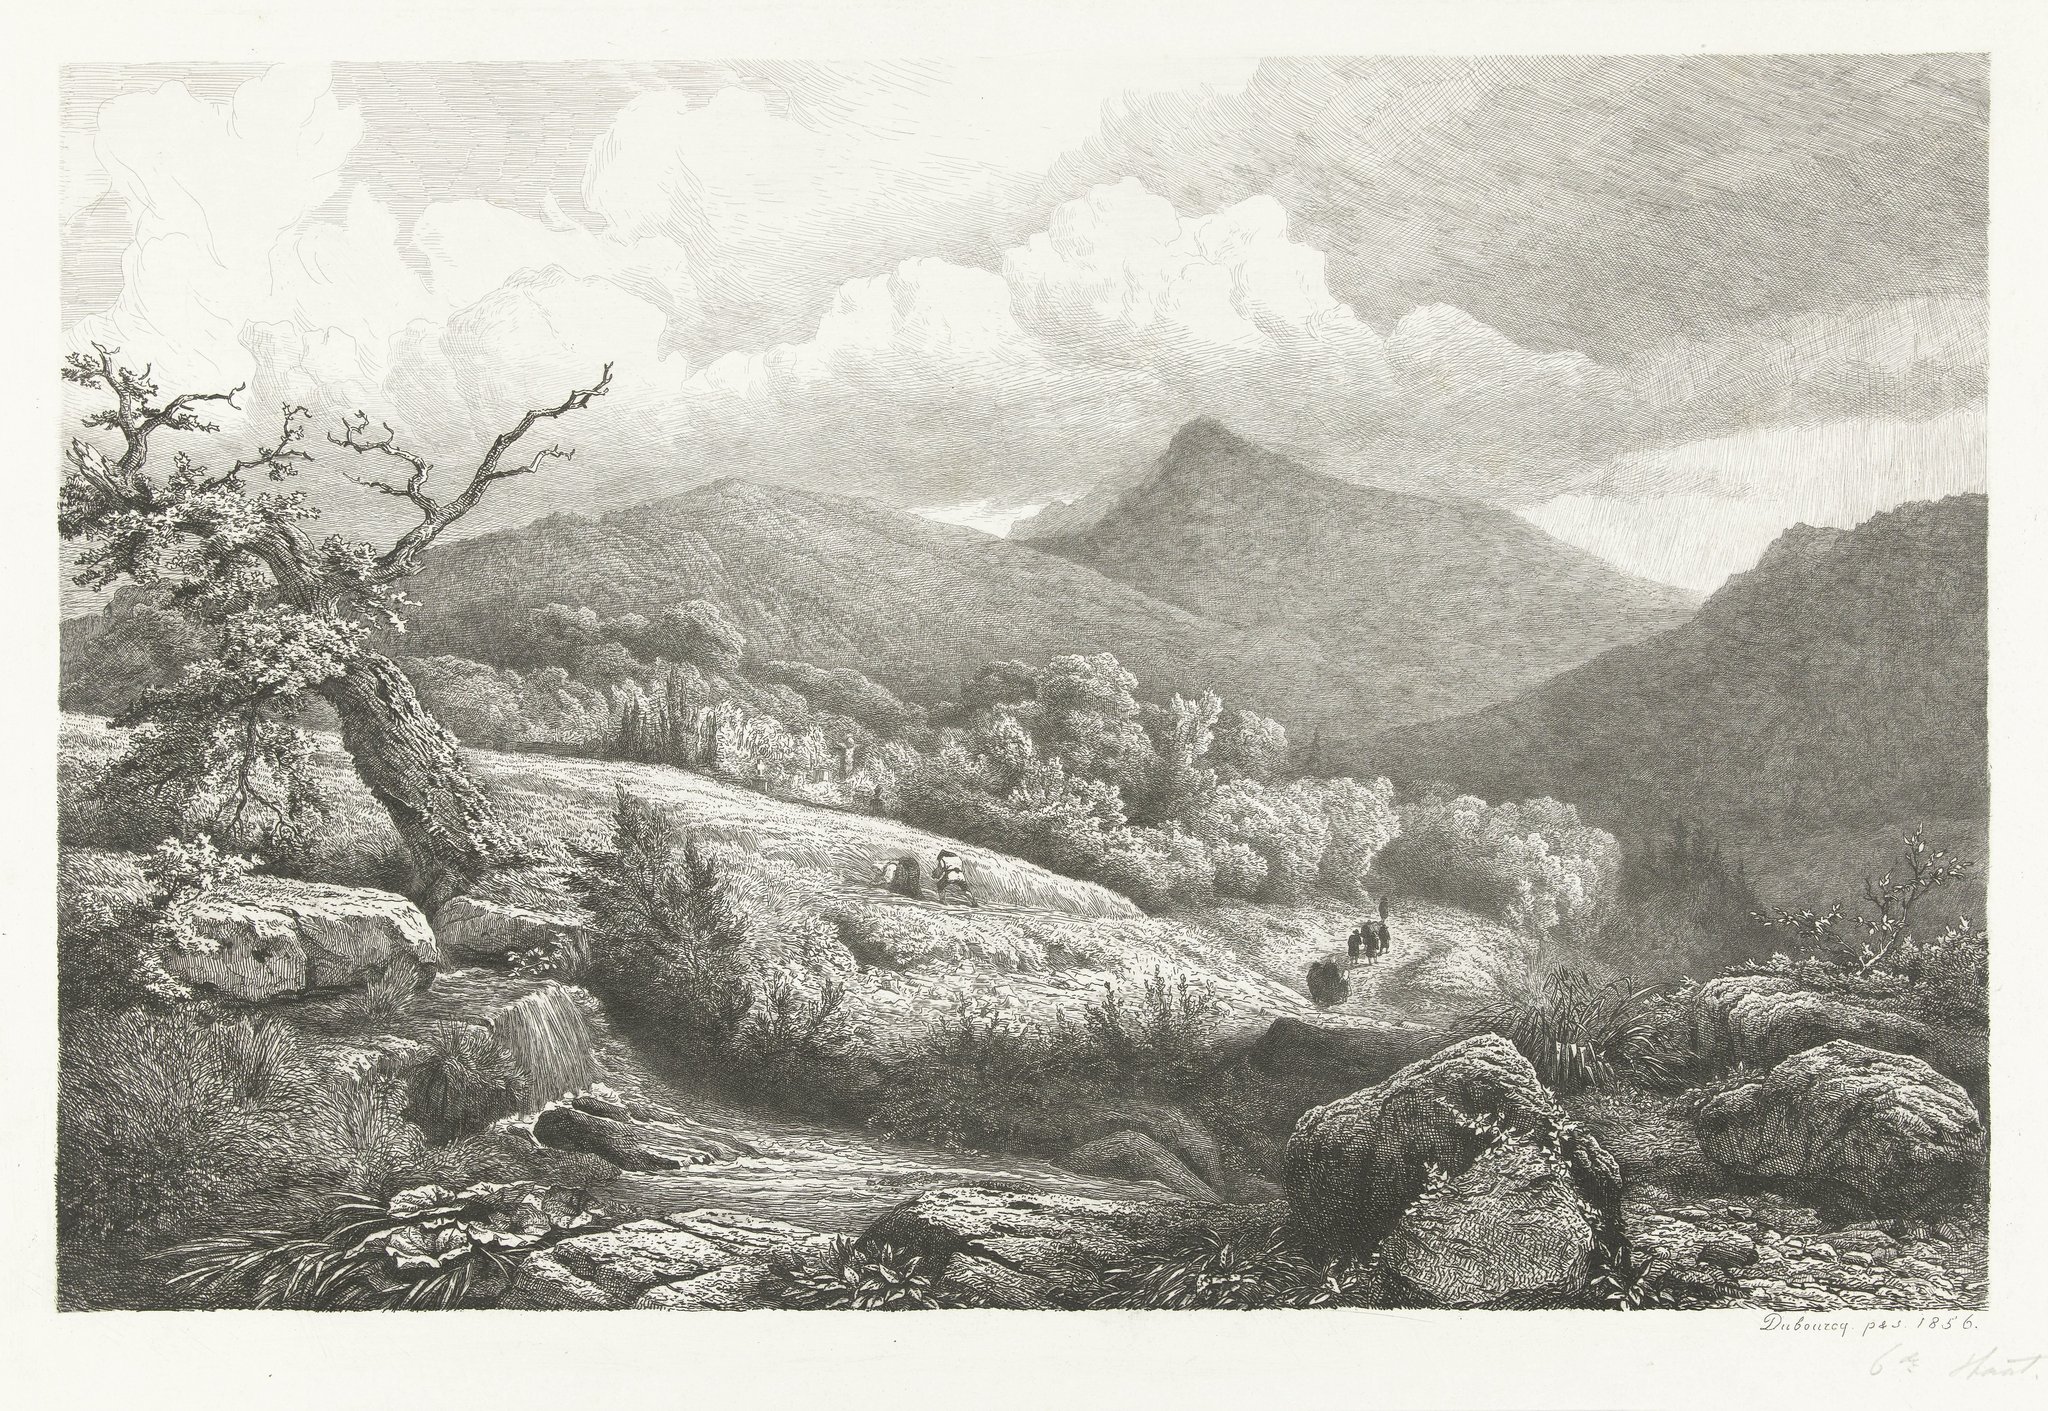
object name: print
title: De begraafplaats te Baden-Baden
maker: pierre louis dubourcq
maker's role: draughtsman, painter, print maker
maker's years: 1815-1873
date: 1856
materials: paper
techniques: etching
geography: netherlands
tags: landscape with other man-made constructions not mentioned above, e.g.: graveyards, playgrounds, etc.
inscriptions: collector's mark: Lugt 2228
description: De begraafplaats te Baden-Baden. Berglandschap met een kleine begrafenisstoet op weg naar de begraafplaats links tussen de bomen. Op de voorgrond een watervalletje.